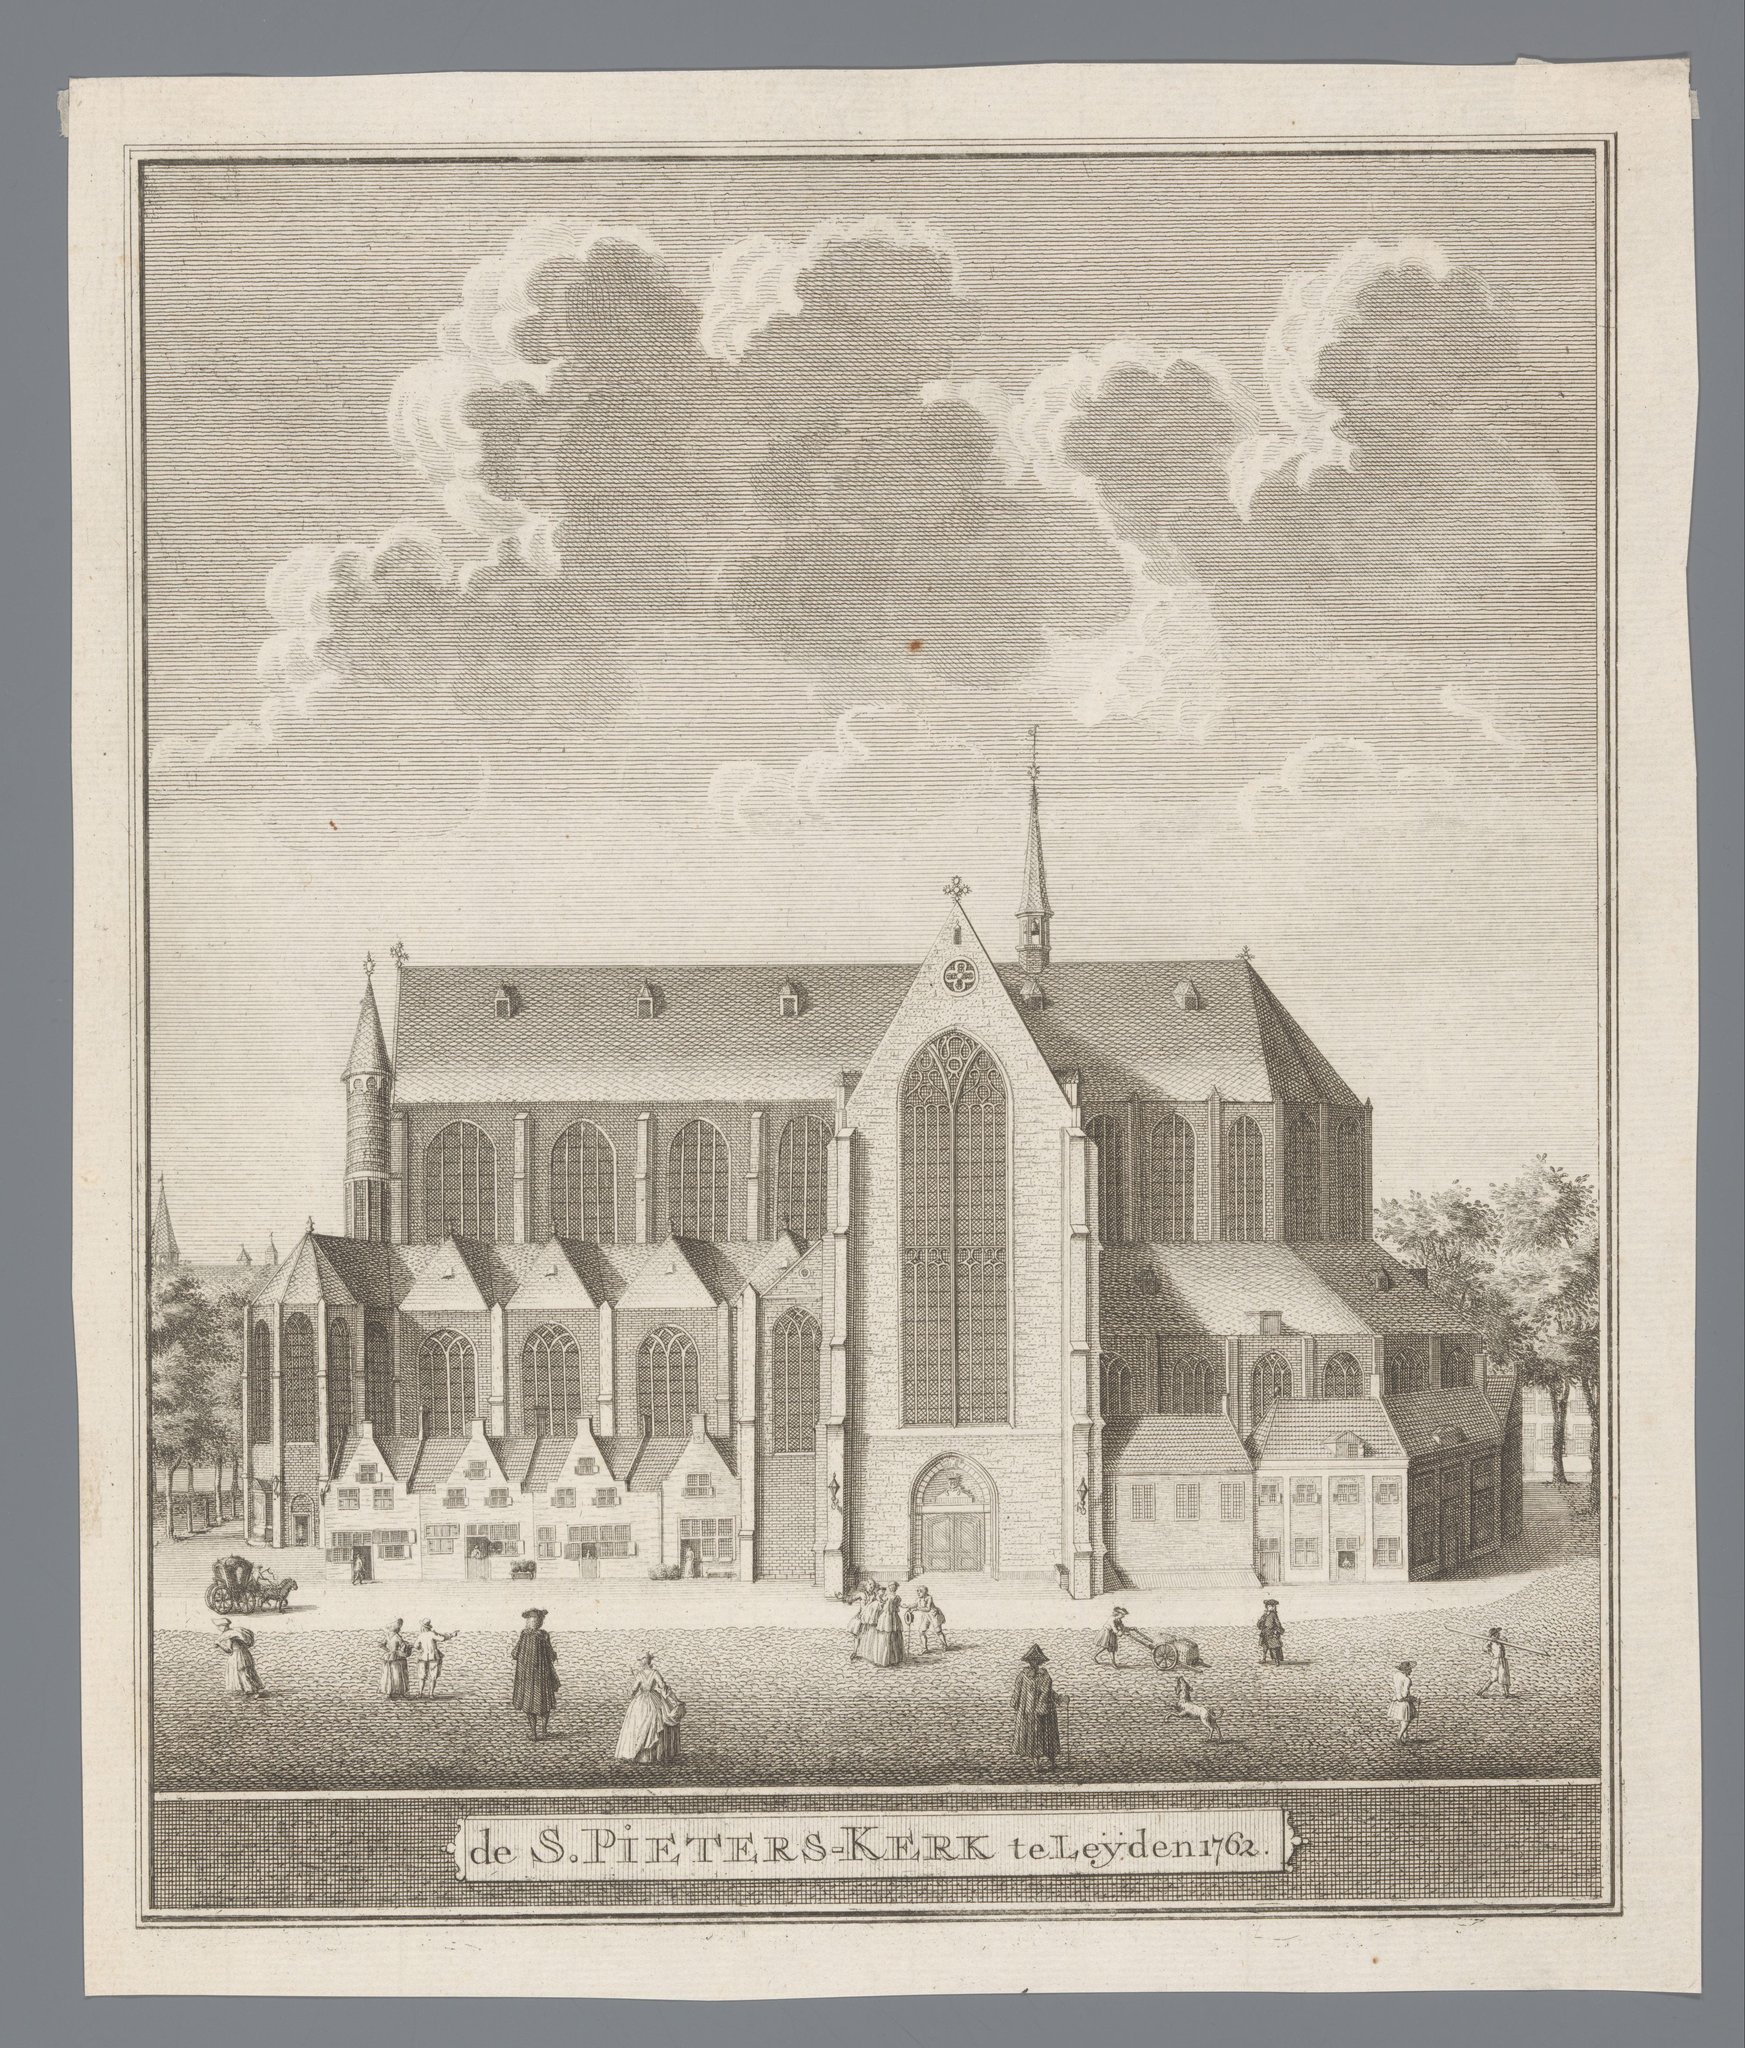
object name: book illustration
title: De S. Pieters-kerk te Leijden 1762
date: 1762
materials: paper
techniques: engraving, etching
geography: leiden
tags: church (exterior), square, place, circus, etc. (+ city(-scape) with figures, staffage)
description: Prent uit: Beschrijving der stad Leyden, haar gelegenheid, oorsprong (...). Leiden: Weduwe Abraham Honkoop en Cornelis van Hoogeveen junior, 1762, dl. 1, tussen p. 24 en 25.